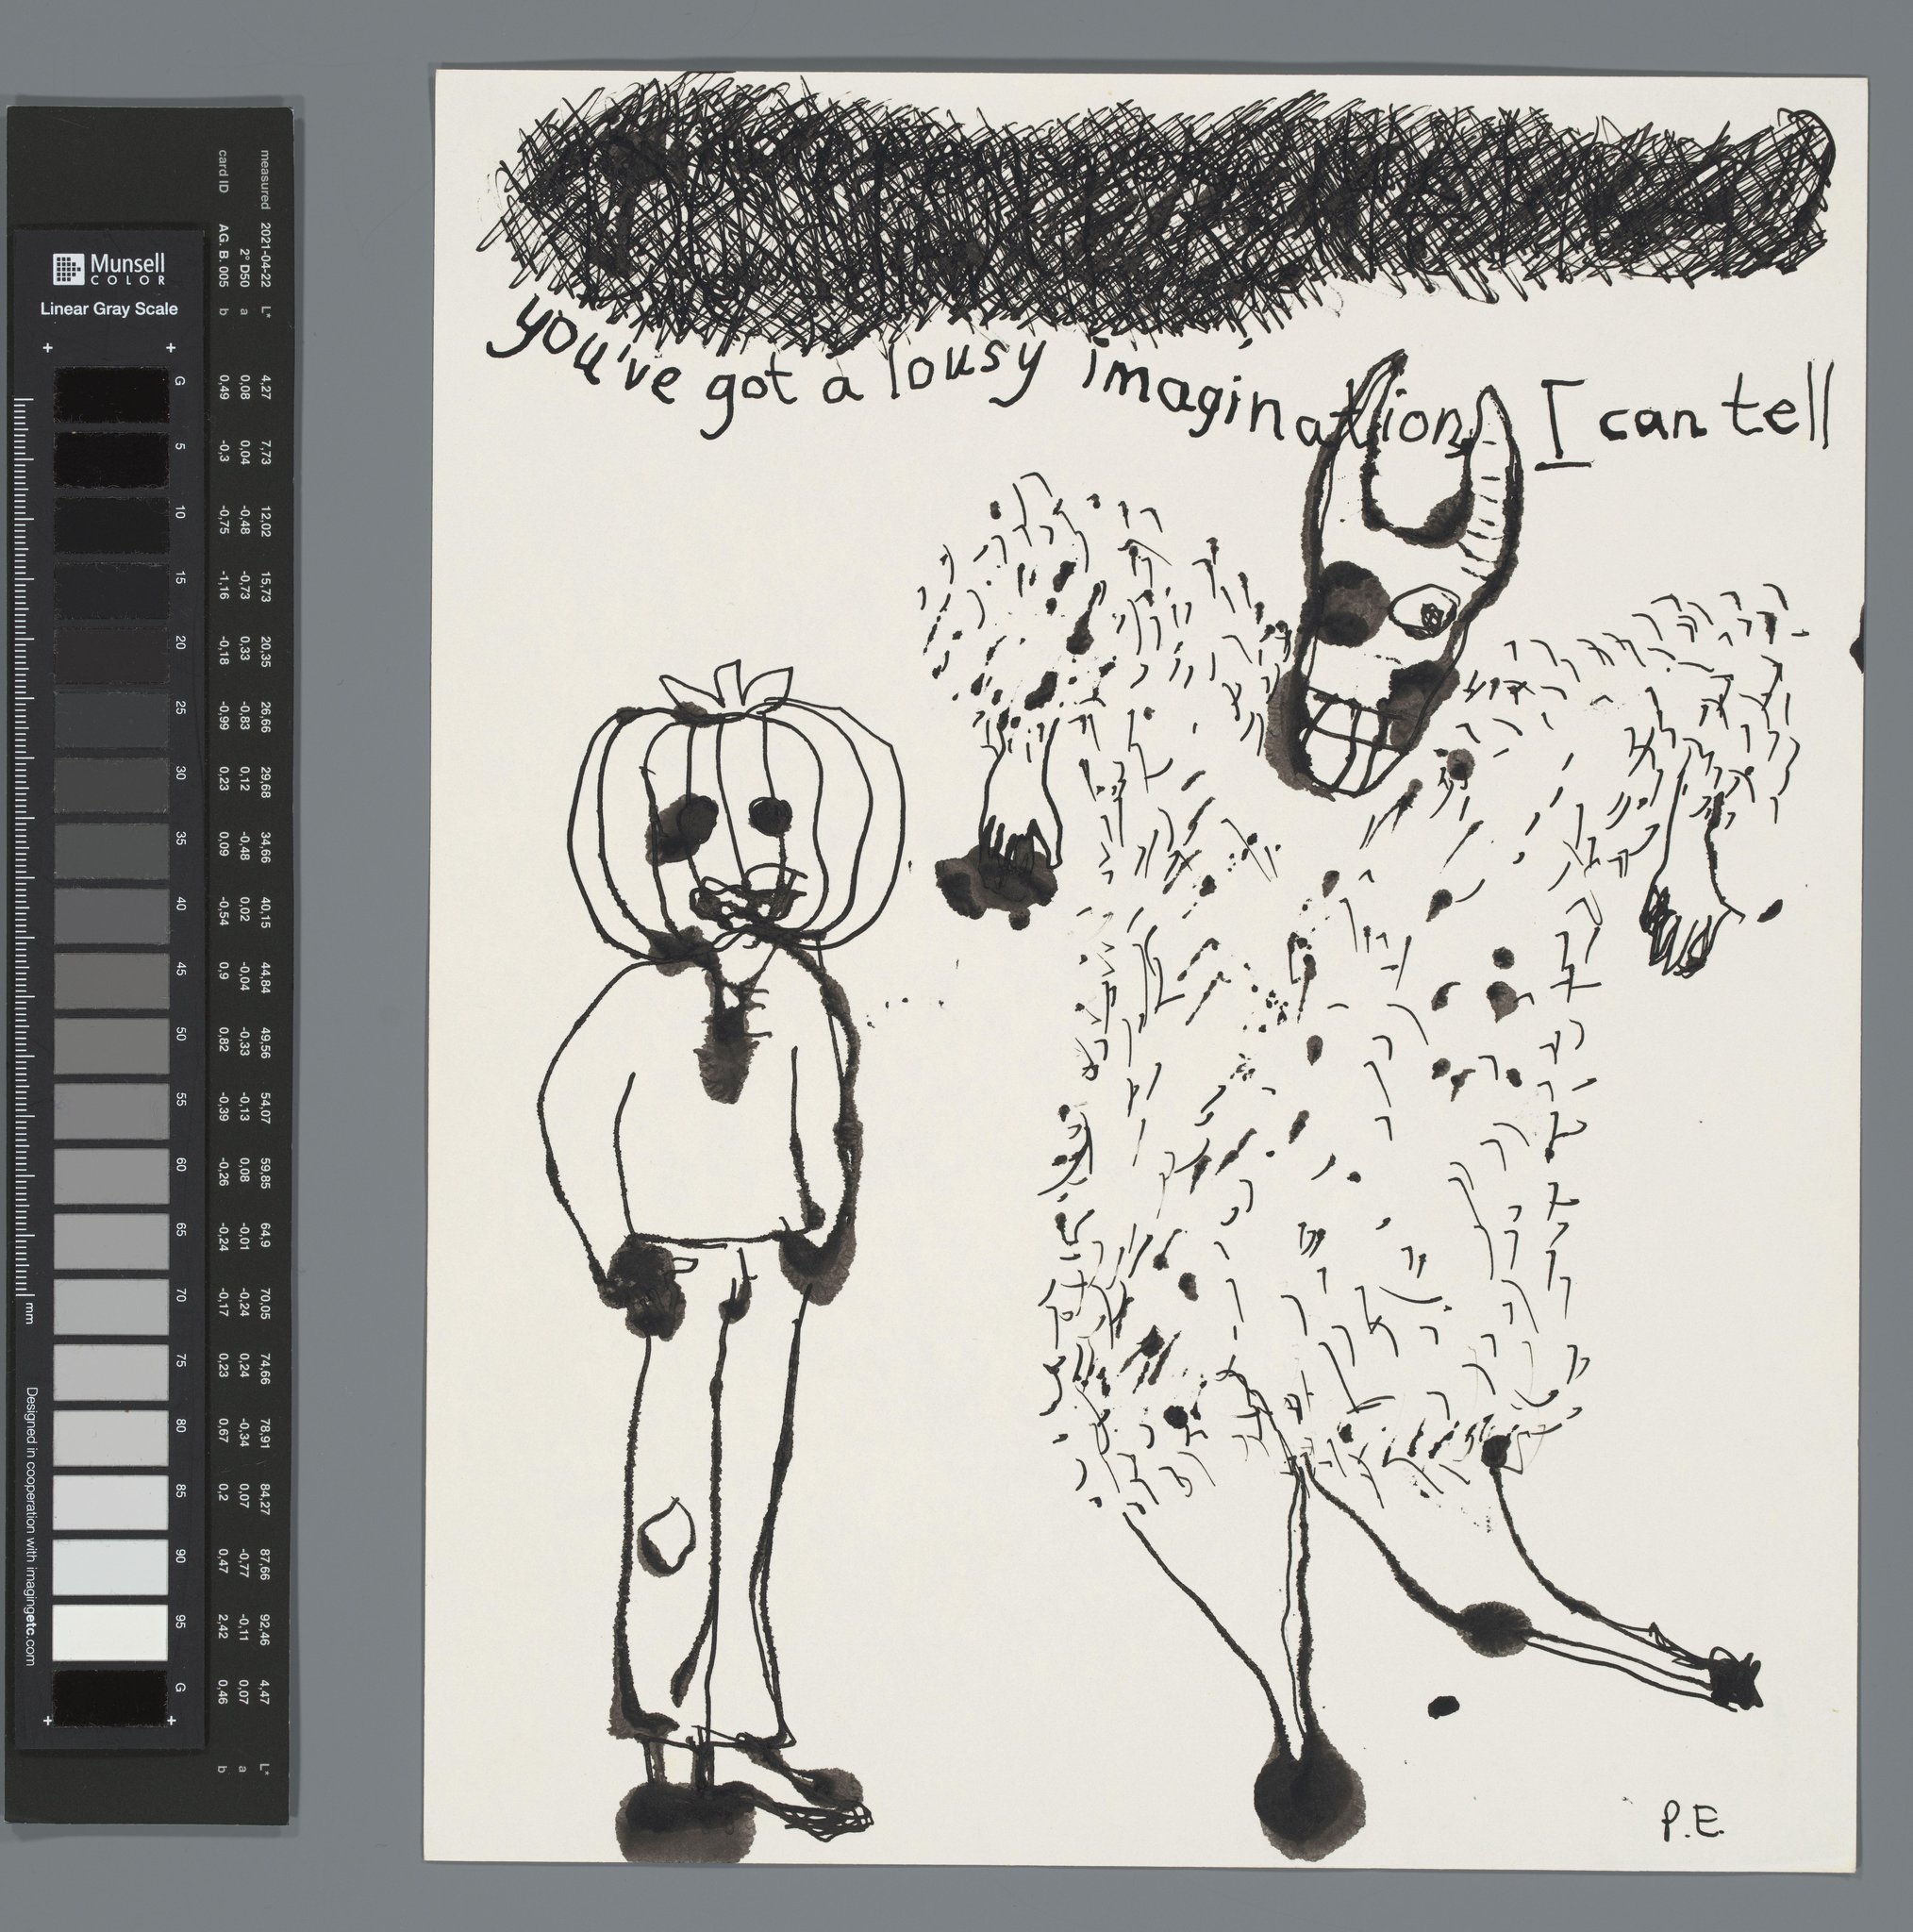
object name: drawing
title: You've got a lousy imagination I can tell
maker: pam emmerik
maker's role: artist, draughtsman, painter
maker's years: 1964-2015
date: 1997-1998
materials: ink, paper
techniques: drawing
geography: netherlands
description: Twee gemaskerde figuren: een met een pompoenmasker en een met een gehoornd koeienmasker en vachtkostuum staan naast elkaar.